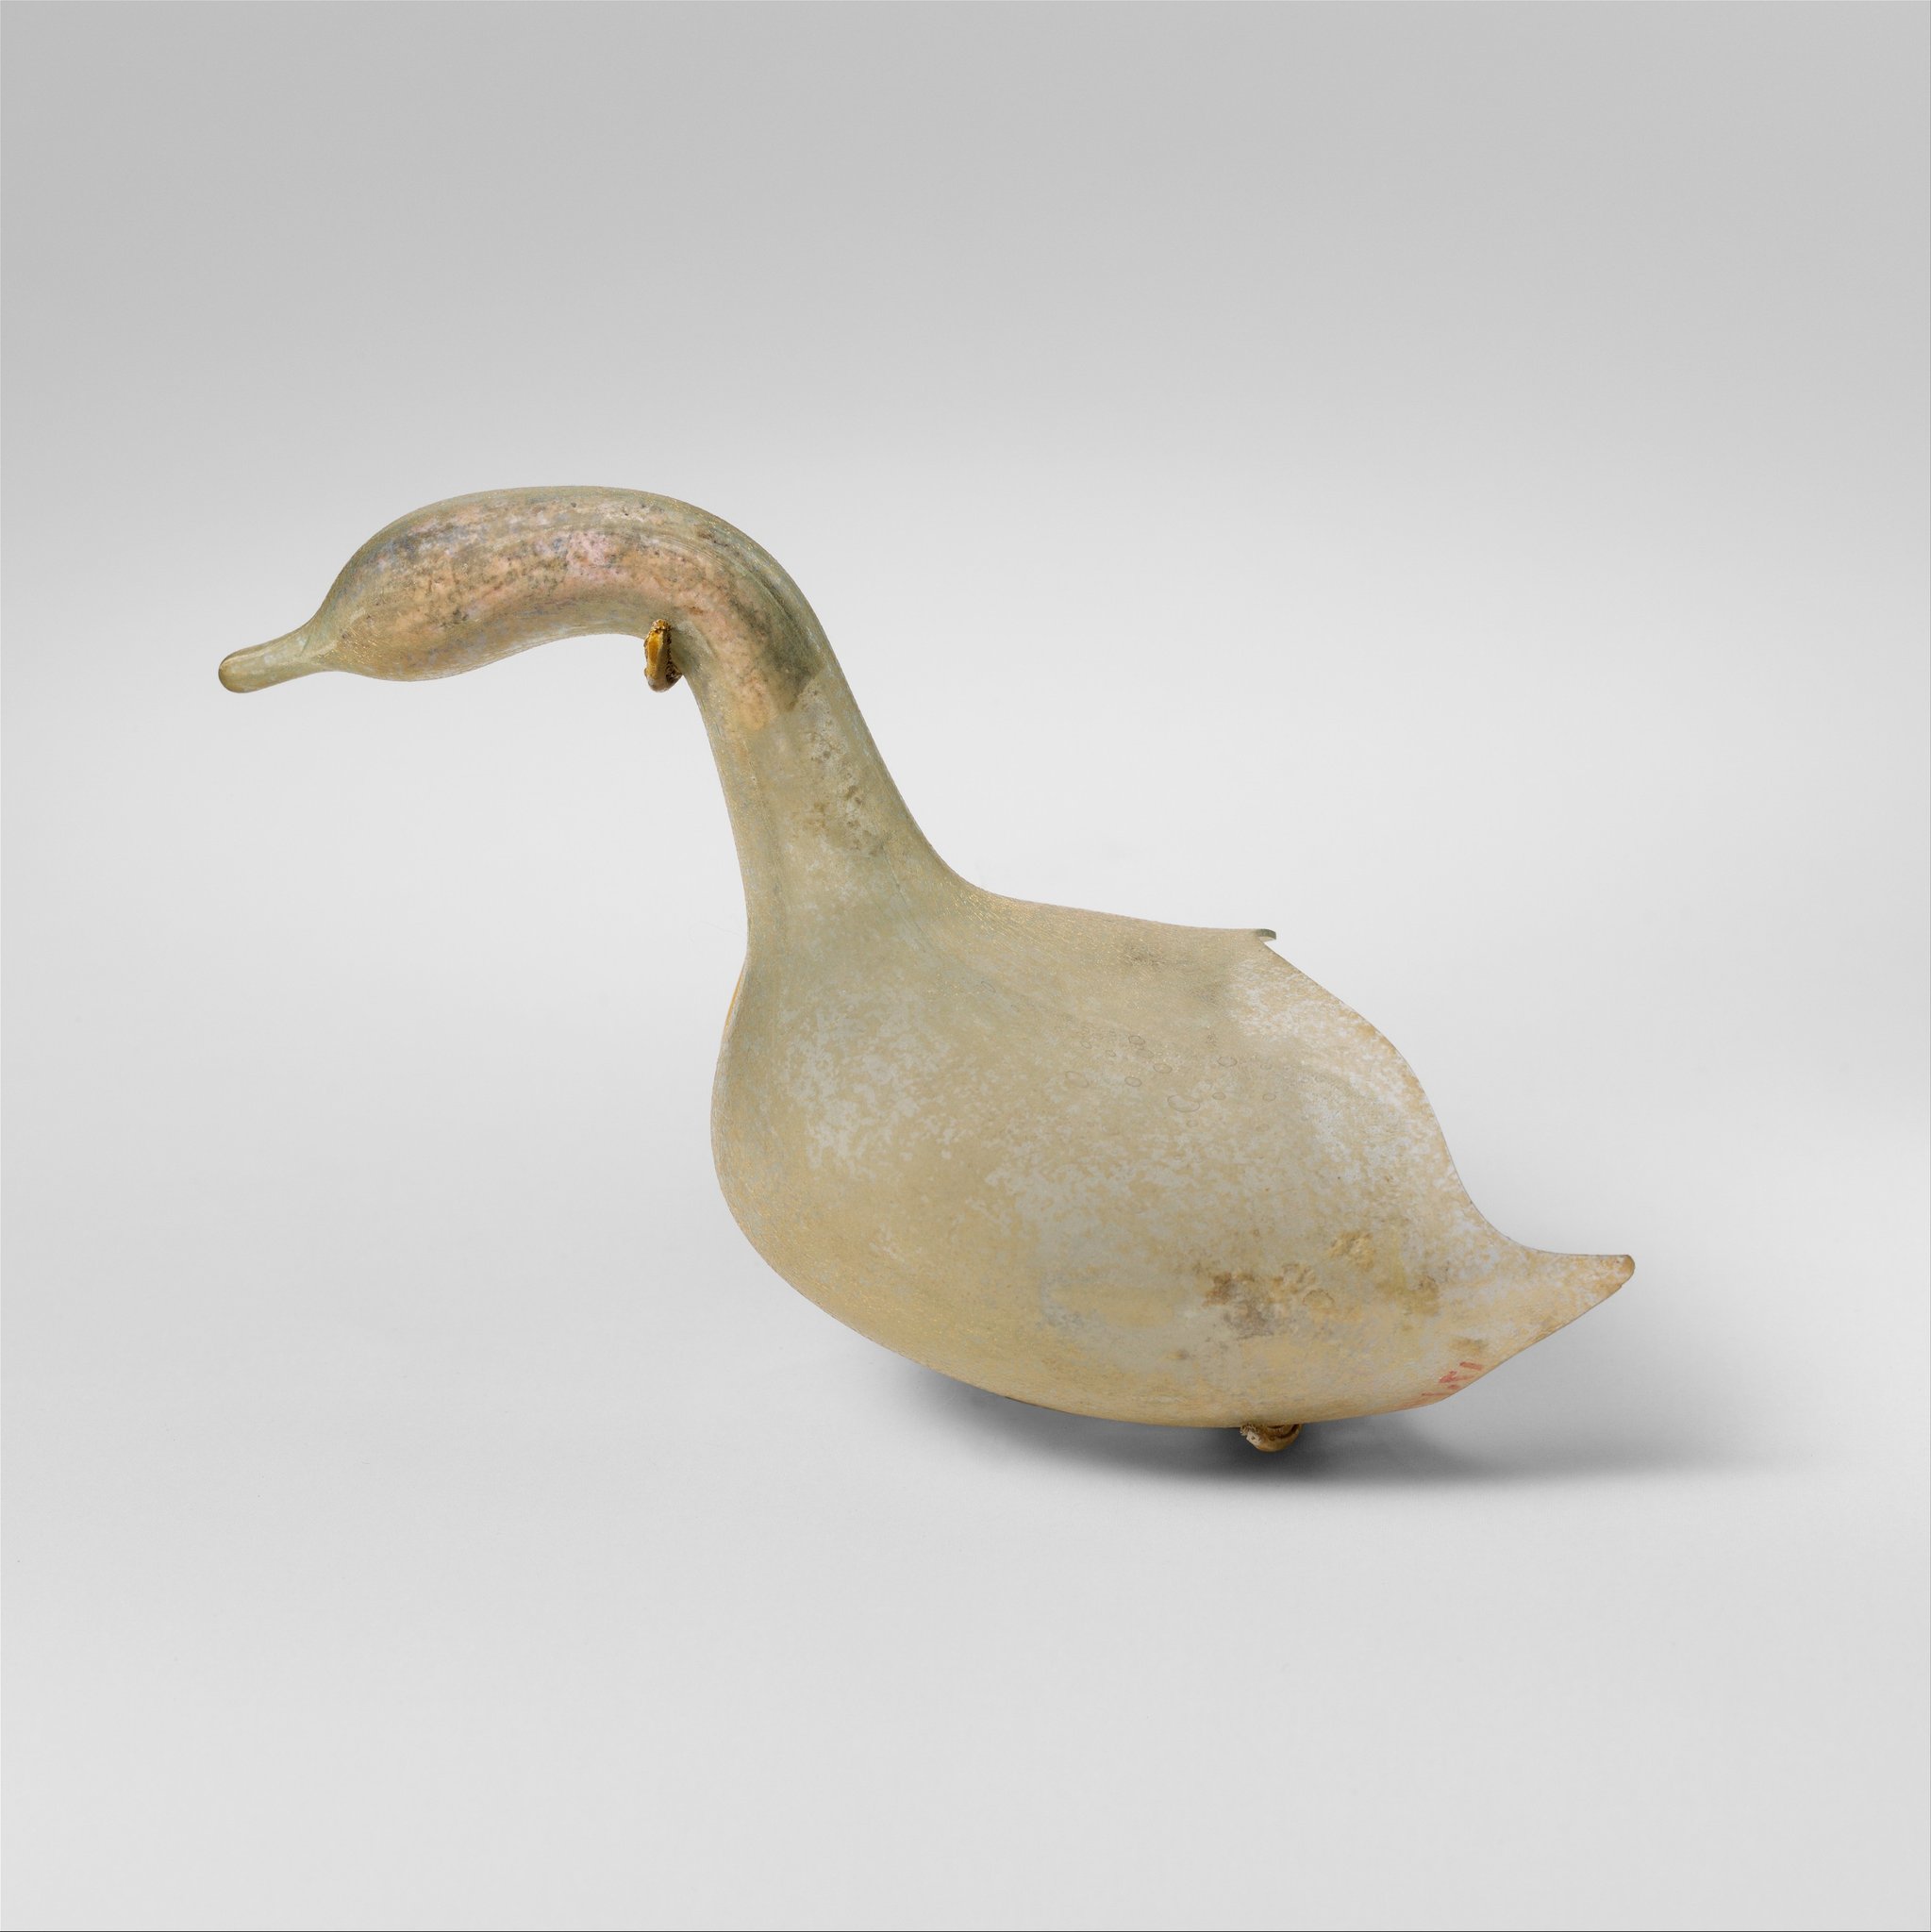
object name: bottle in the form of a bird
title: Glass bottle in the shape of a bird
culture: roman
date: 1-100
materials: glass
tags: birds